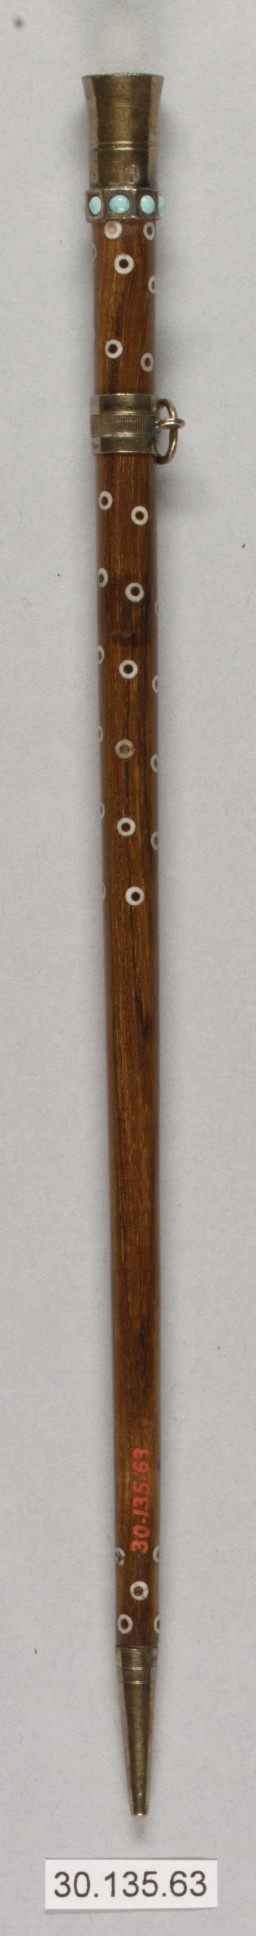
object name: needle sheath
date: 1801-1900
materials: ivory, metal, stone, wood